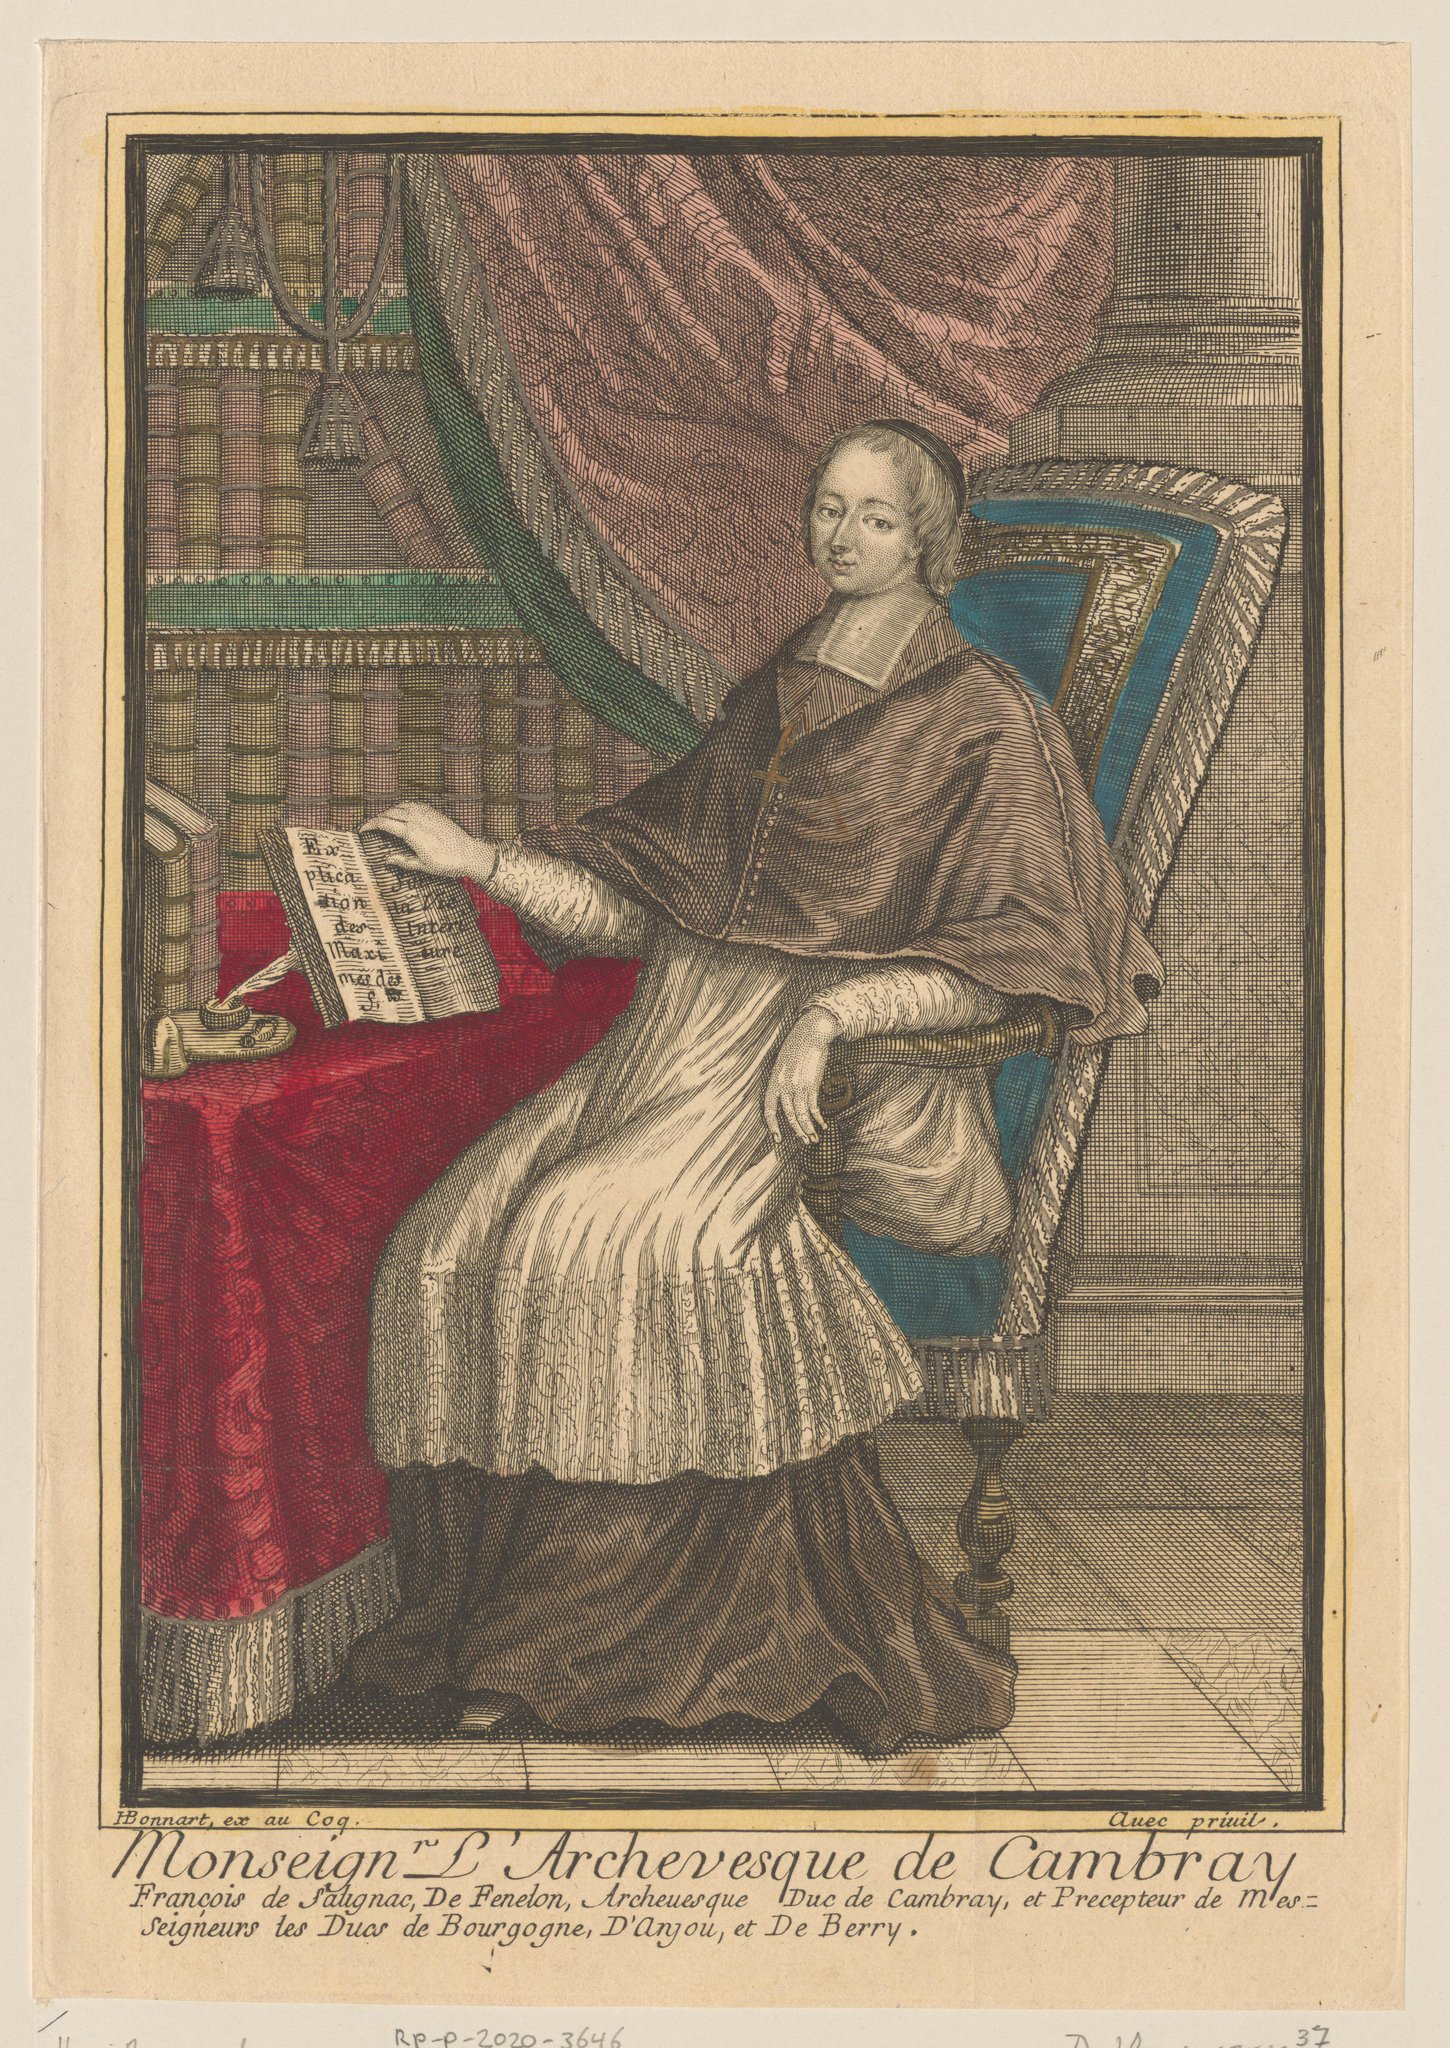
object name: print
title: Portret van François Fénelon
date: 1695-1711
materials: paper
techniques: engraving, etching, hand coloring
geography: paris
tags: françois fénelon, bookshelves, historical persons, book - mm - book open